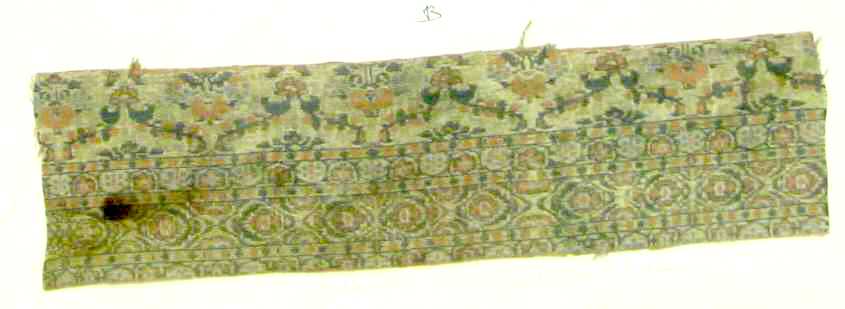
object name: textile fragment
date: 1601-1633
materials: metal thread, silk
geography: iran